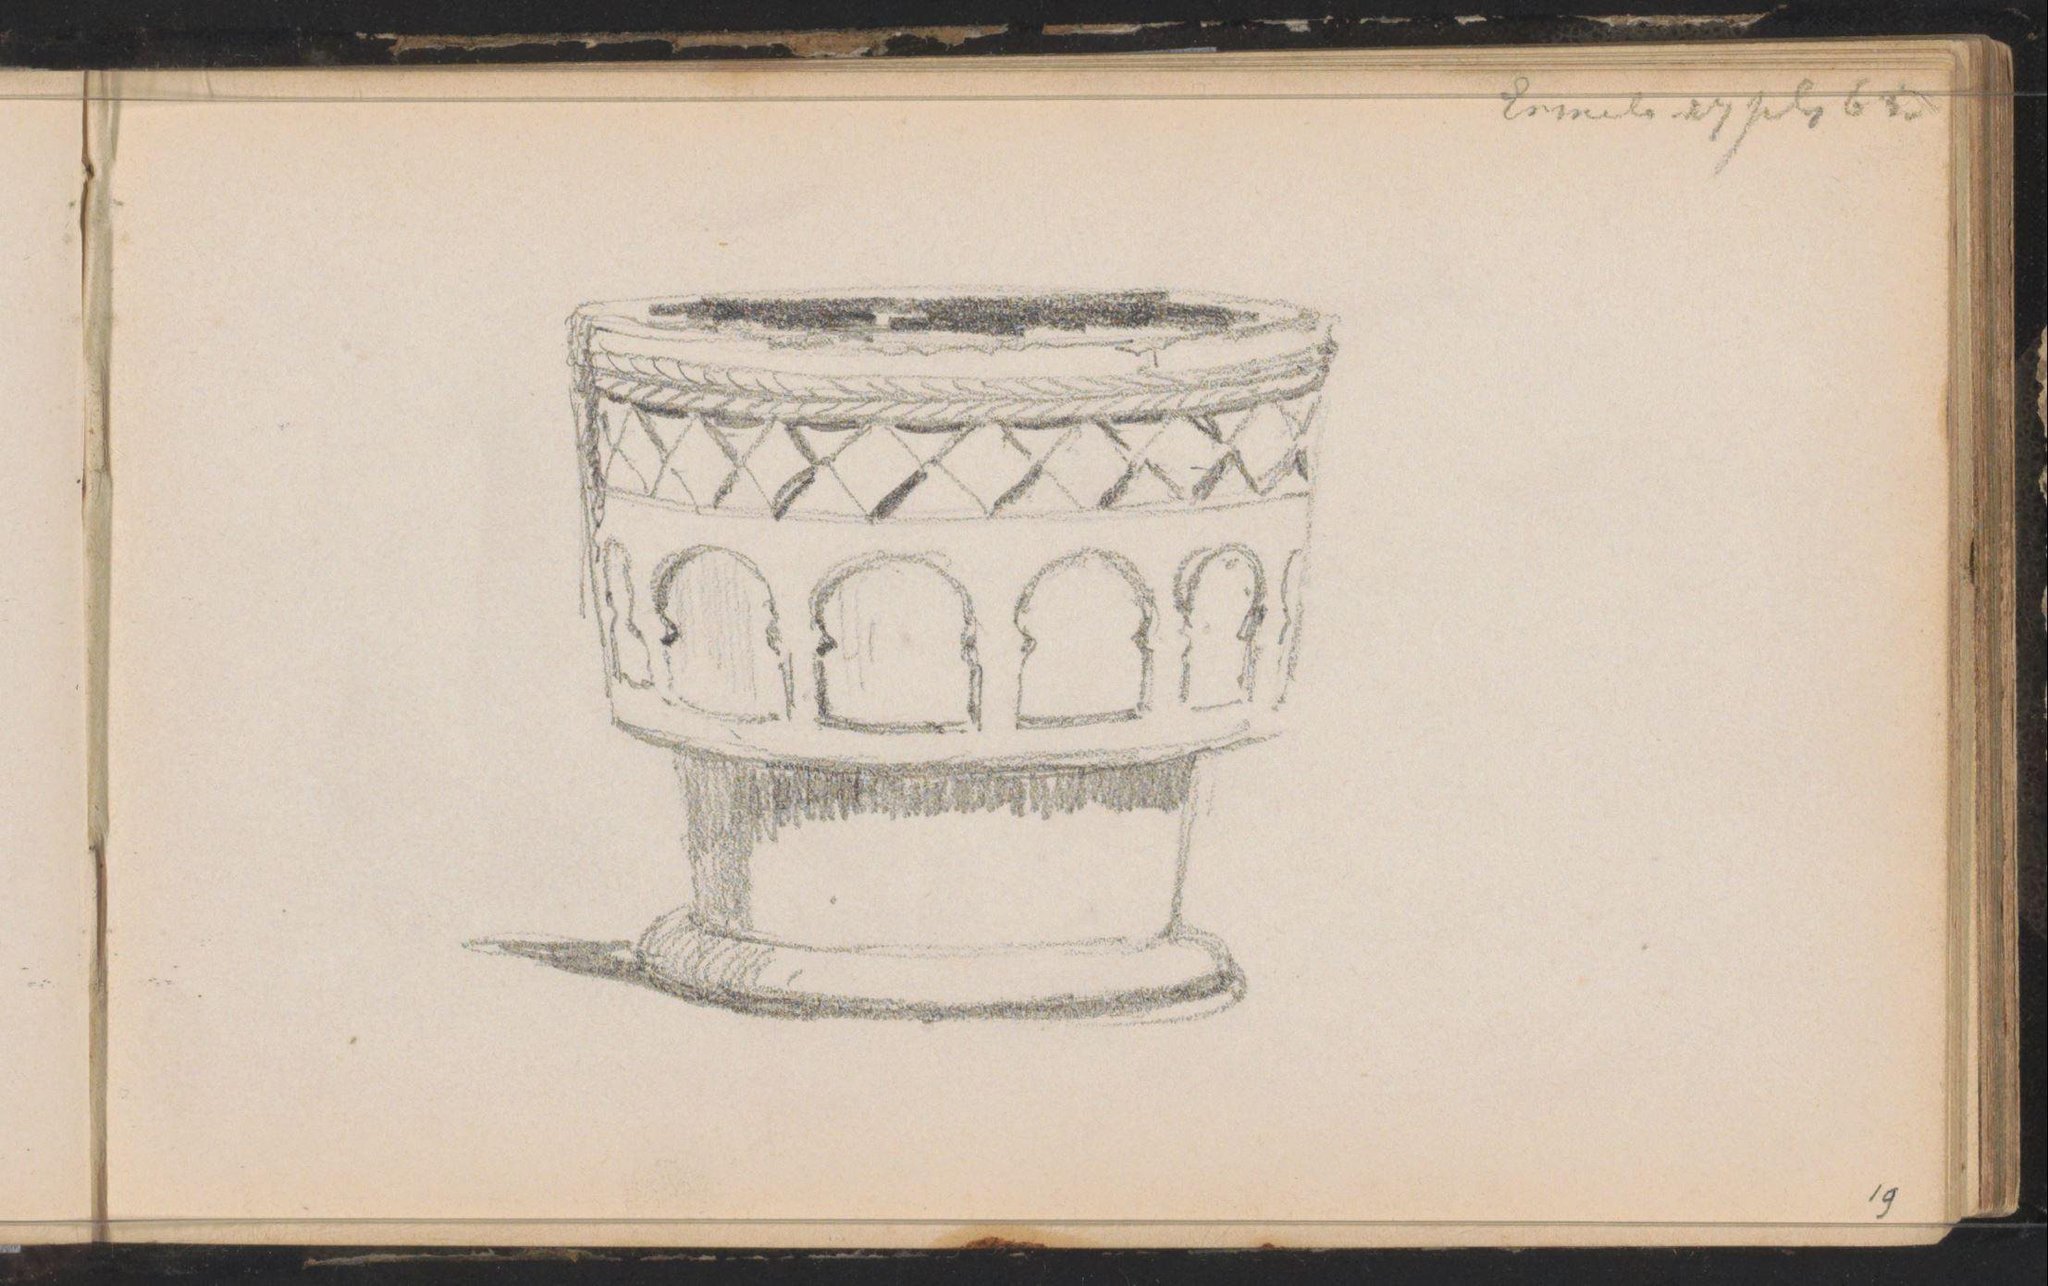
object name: sketchbook leaf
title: Doopvont van de Oude Kerk in Ermelo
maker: cornelis springer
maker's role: draughtsman, painter, print maker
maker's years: 1817-1891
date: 1863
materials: paper, pencil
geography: ermelo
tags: baptismal font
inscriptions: annotation: ‘Ermelo’, date: ‘27 July 63’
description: Doopvont van de Oude Kerk in Ermelo. Blad 19 uit een schetsboek met 55 bladen vervaardigd op de Veluwe en in Noord-Duitsland.